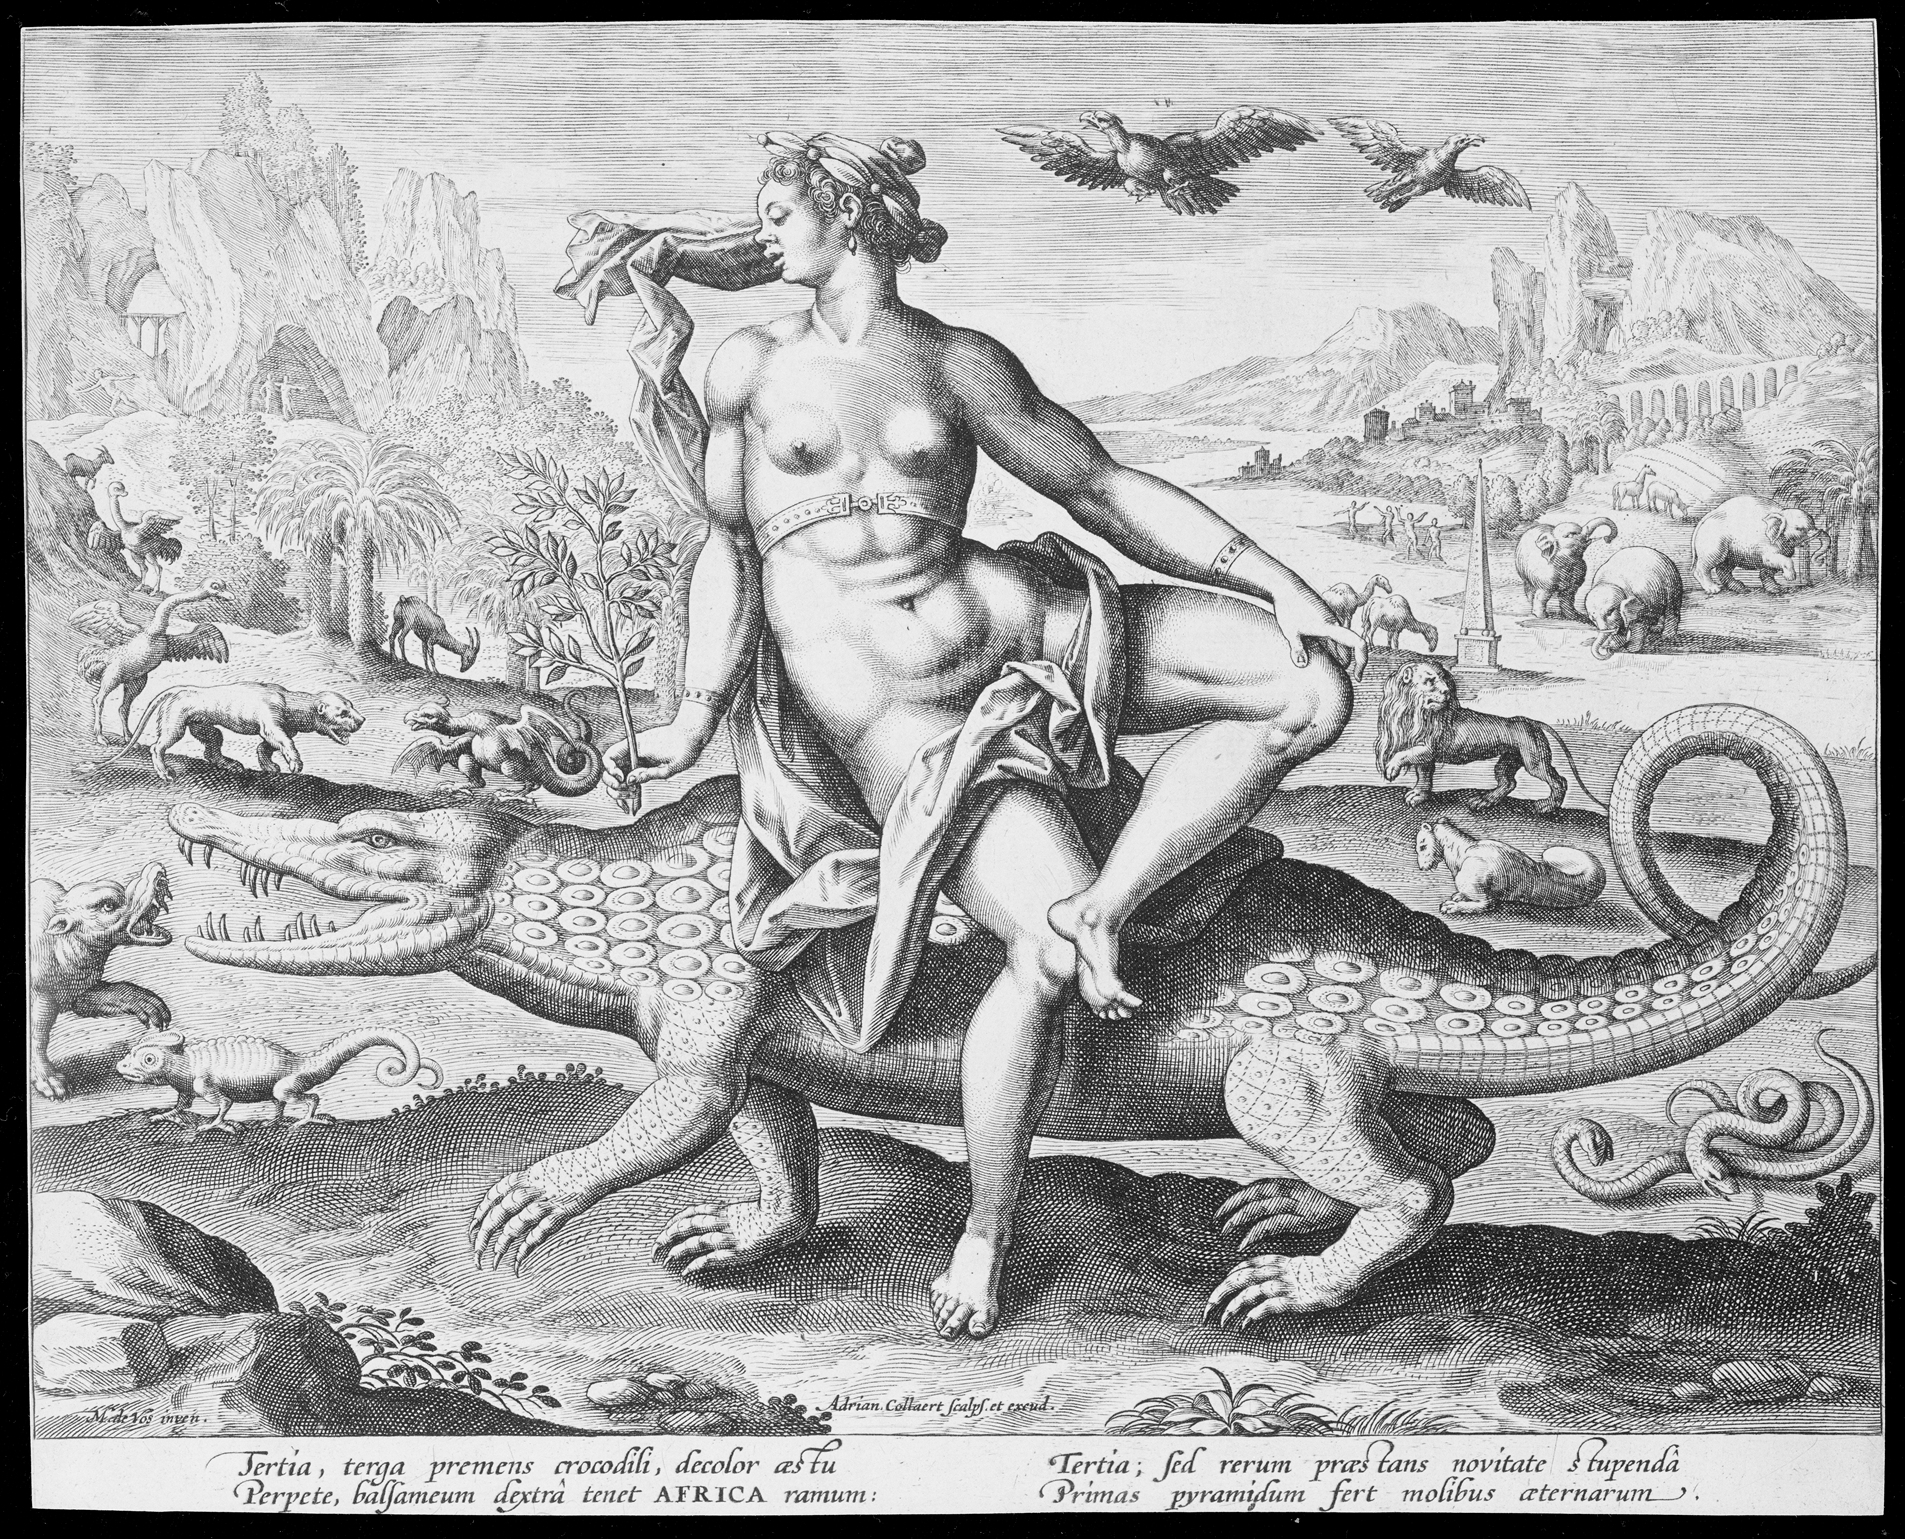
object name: print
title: Allegory of Africa, from "The Four Continents"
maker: adriaen collaert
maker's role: artist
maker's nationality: netherlandish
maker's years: 1560-1618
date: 1580-1600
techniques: engraving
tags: birds,female nudes,crocodiles,elephants,lions